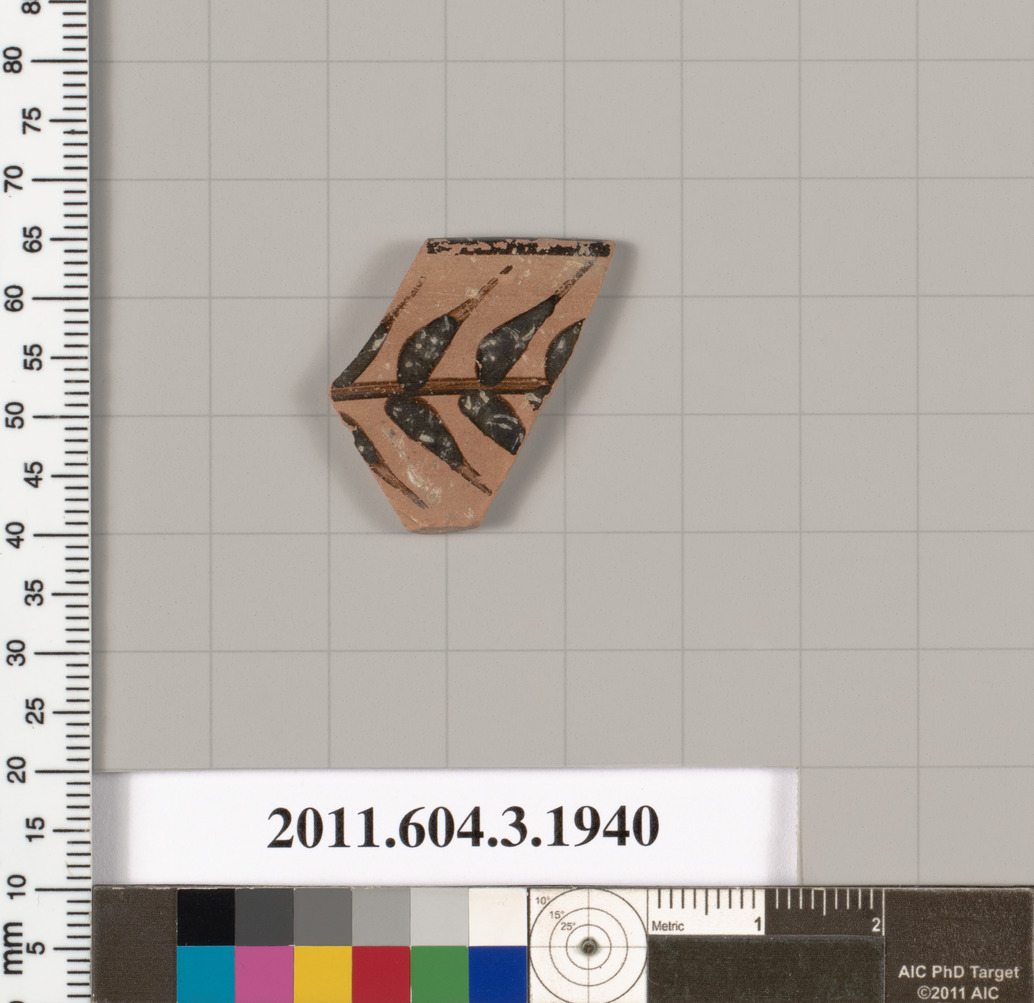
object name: kylix fragment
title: Terracotta rim fragment of a kylix: Cassel cup (drinking cup)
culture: greek, attic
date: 550-526 BCE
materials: terracotta